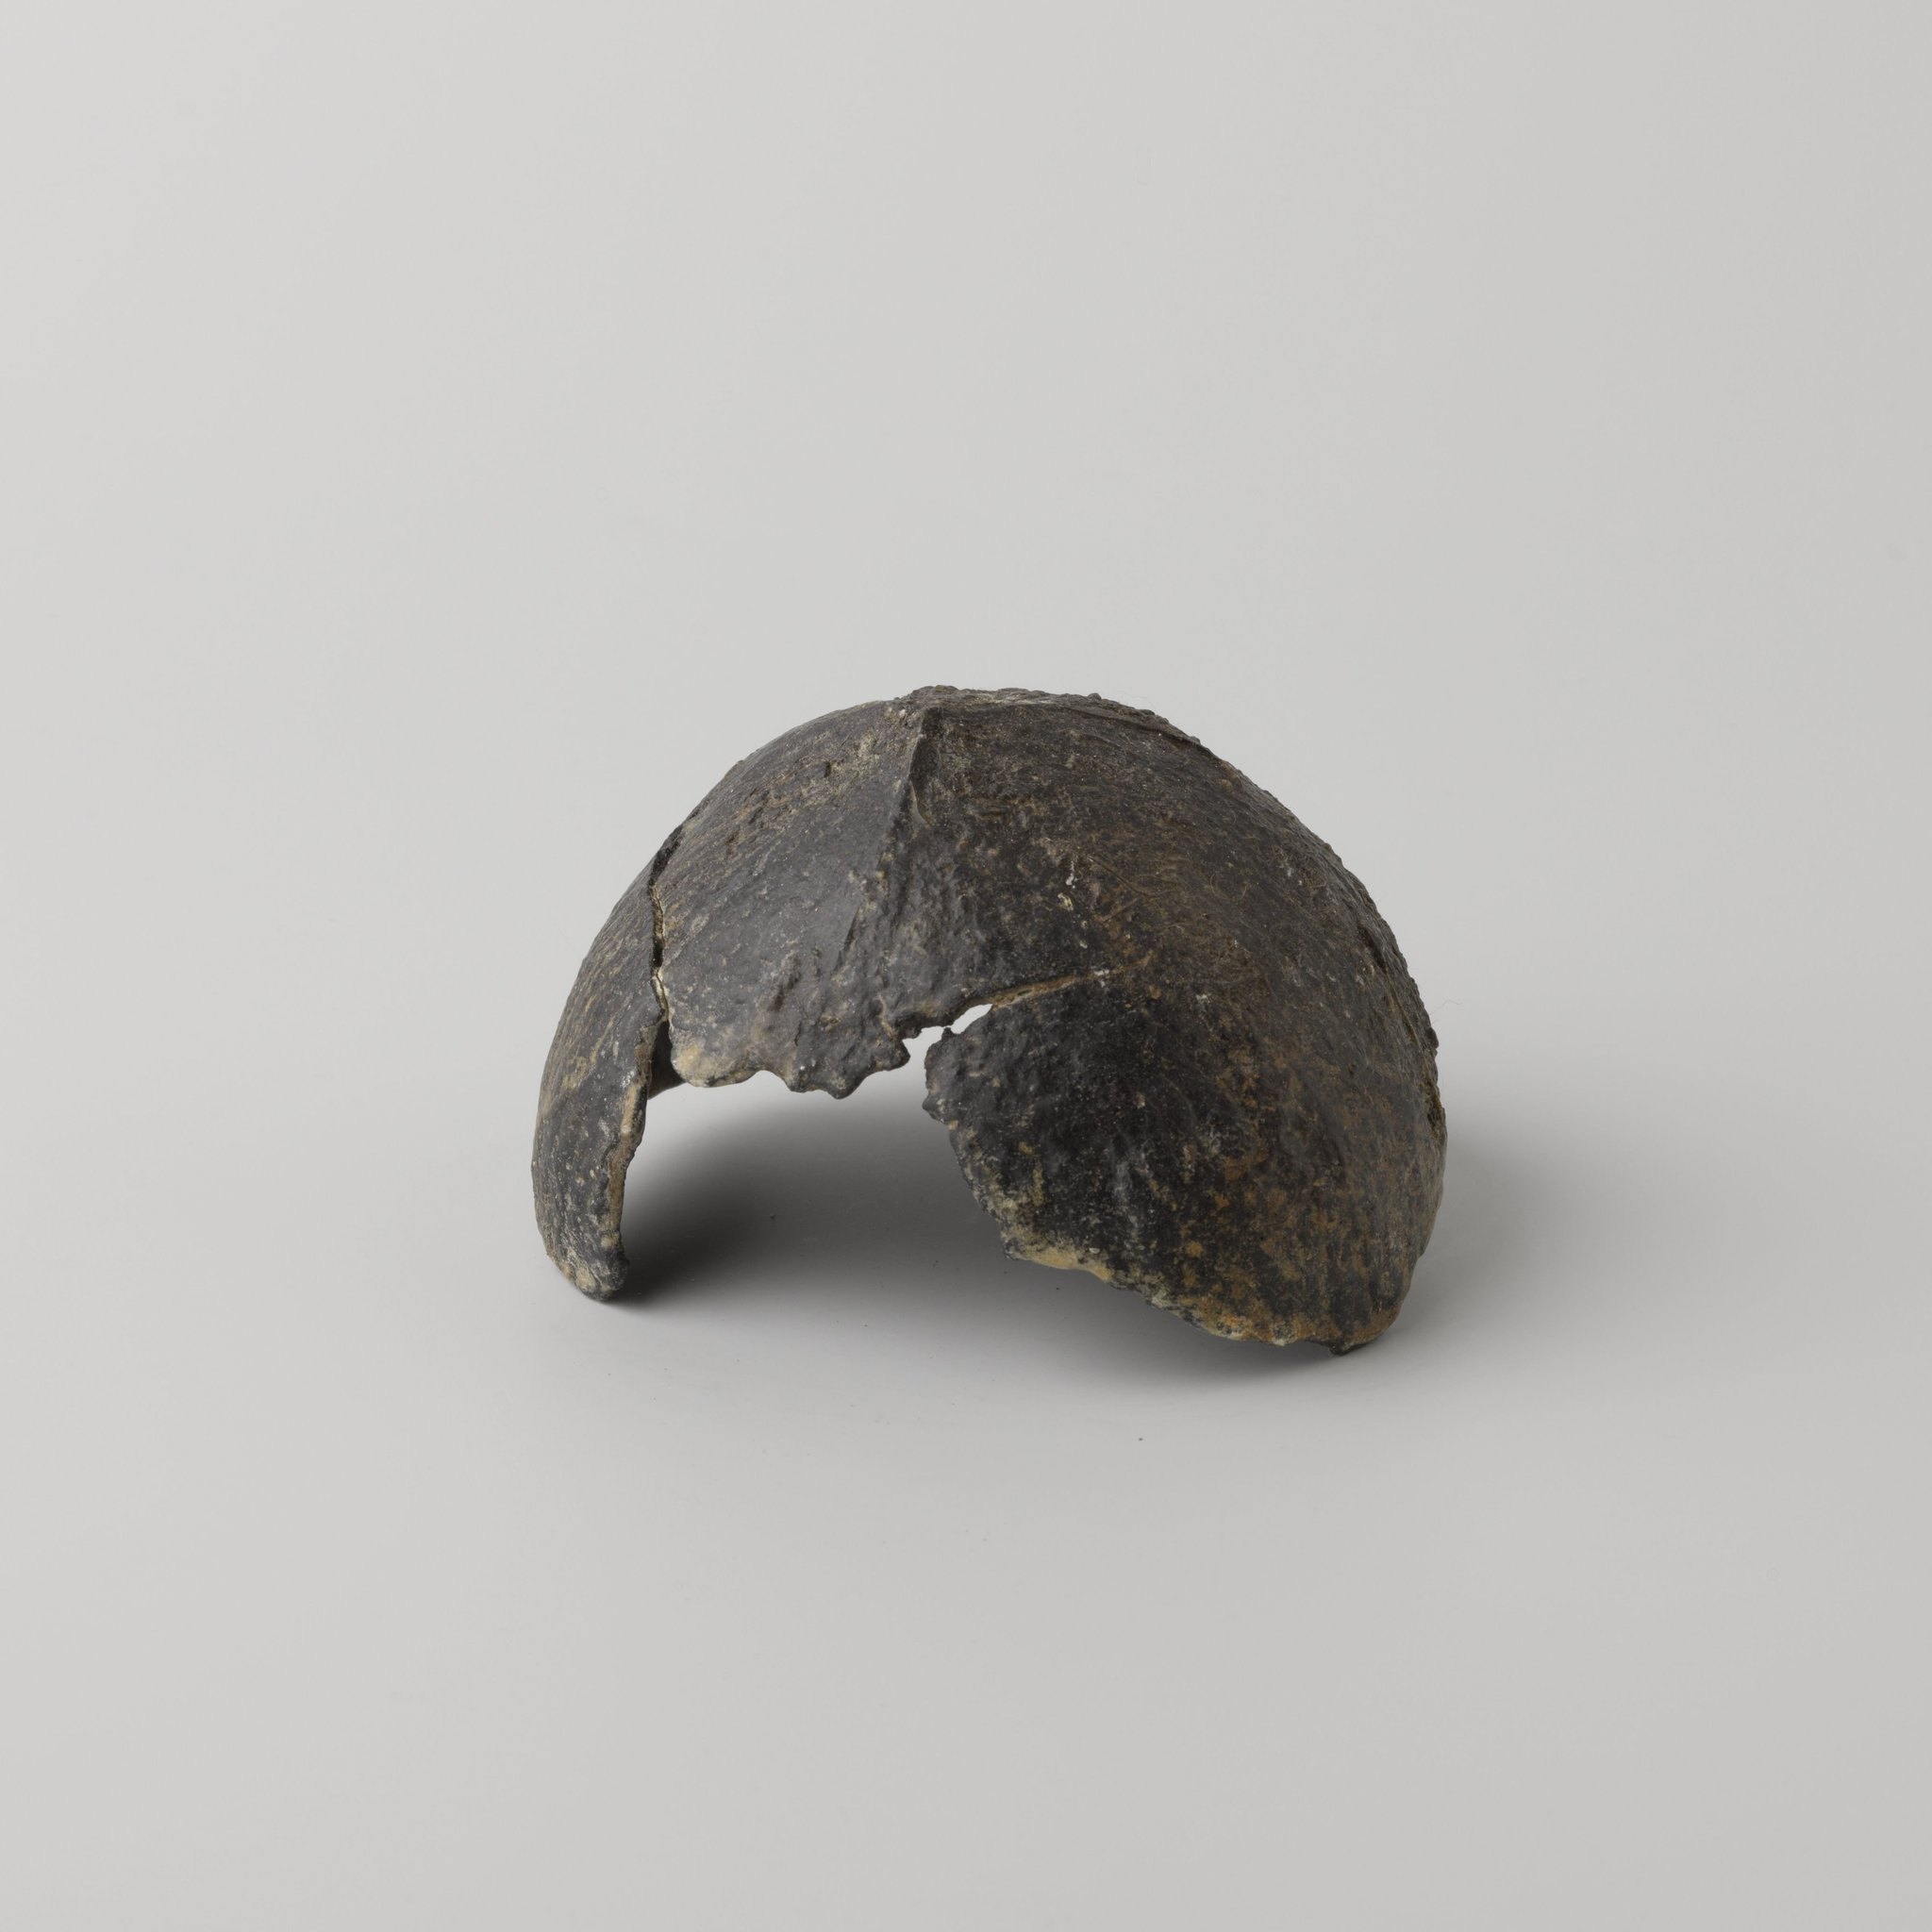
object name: coconut fruit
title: Halve kokosnoot uit V.O.C.-schip de 'Witte Leeuw'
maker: Anonymous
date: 1613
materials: plant material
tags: verenigde oostindische compagnie, sint-helena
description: Halve kokosnoot uit V.O.C.-schip de 'Witte Leeuw'. Grofweg de hele bovenzijde.